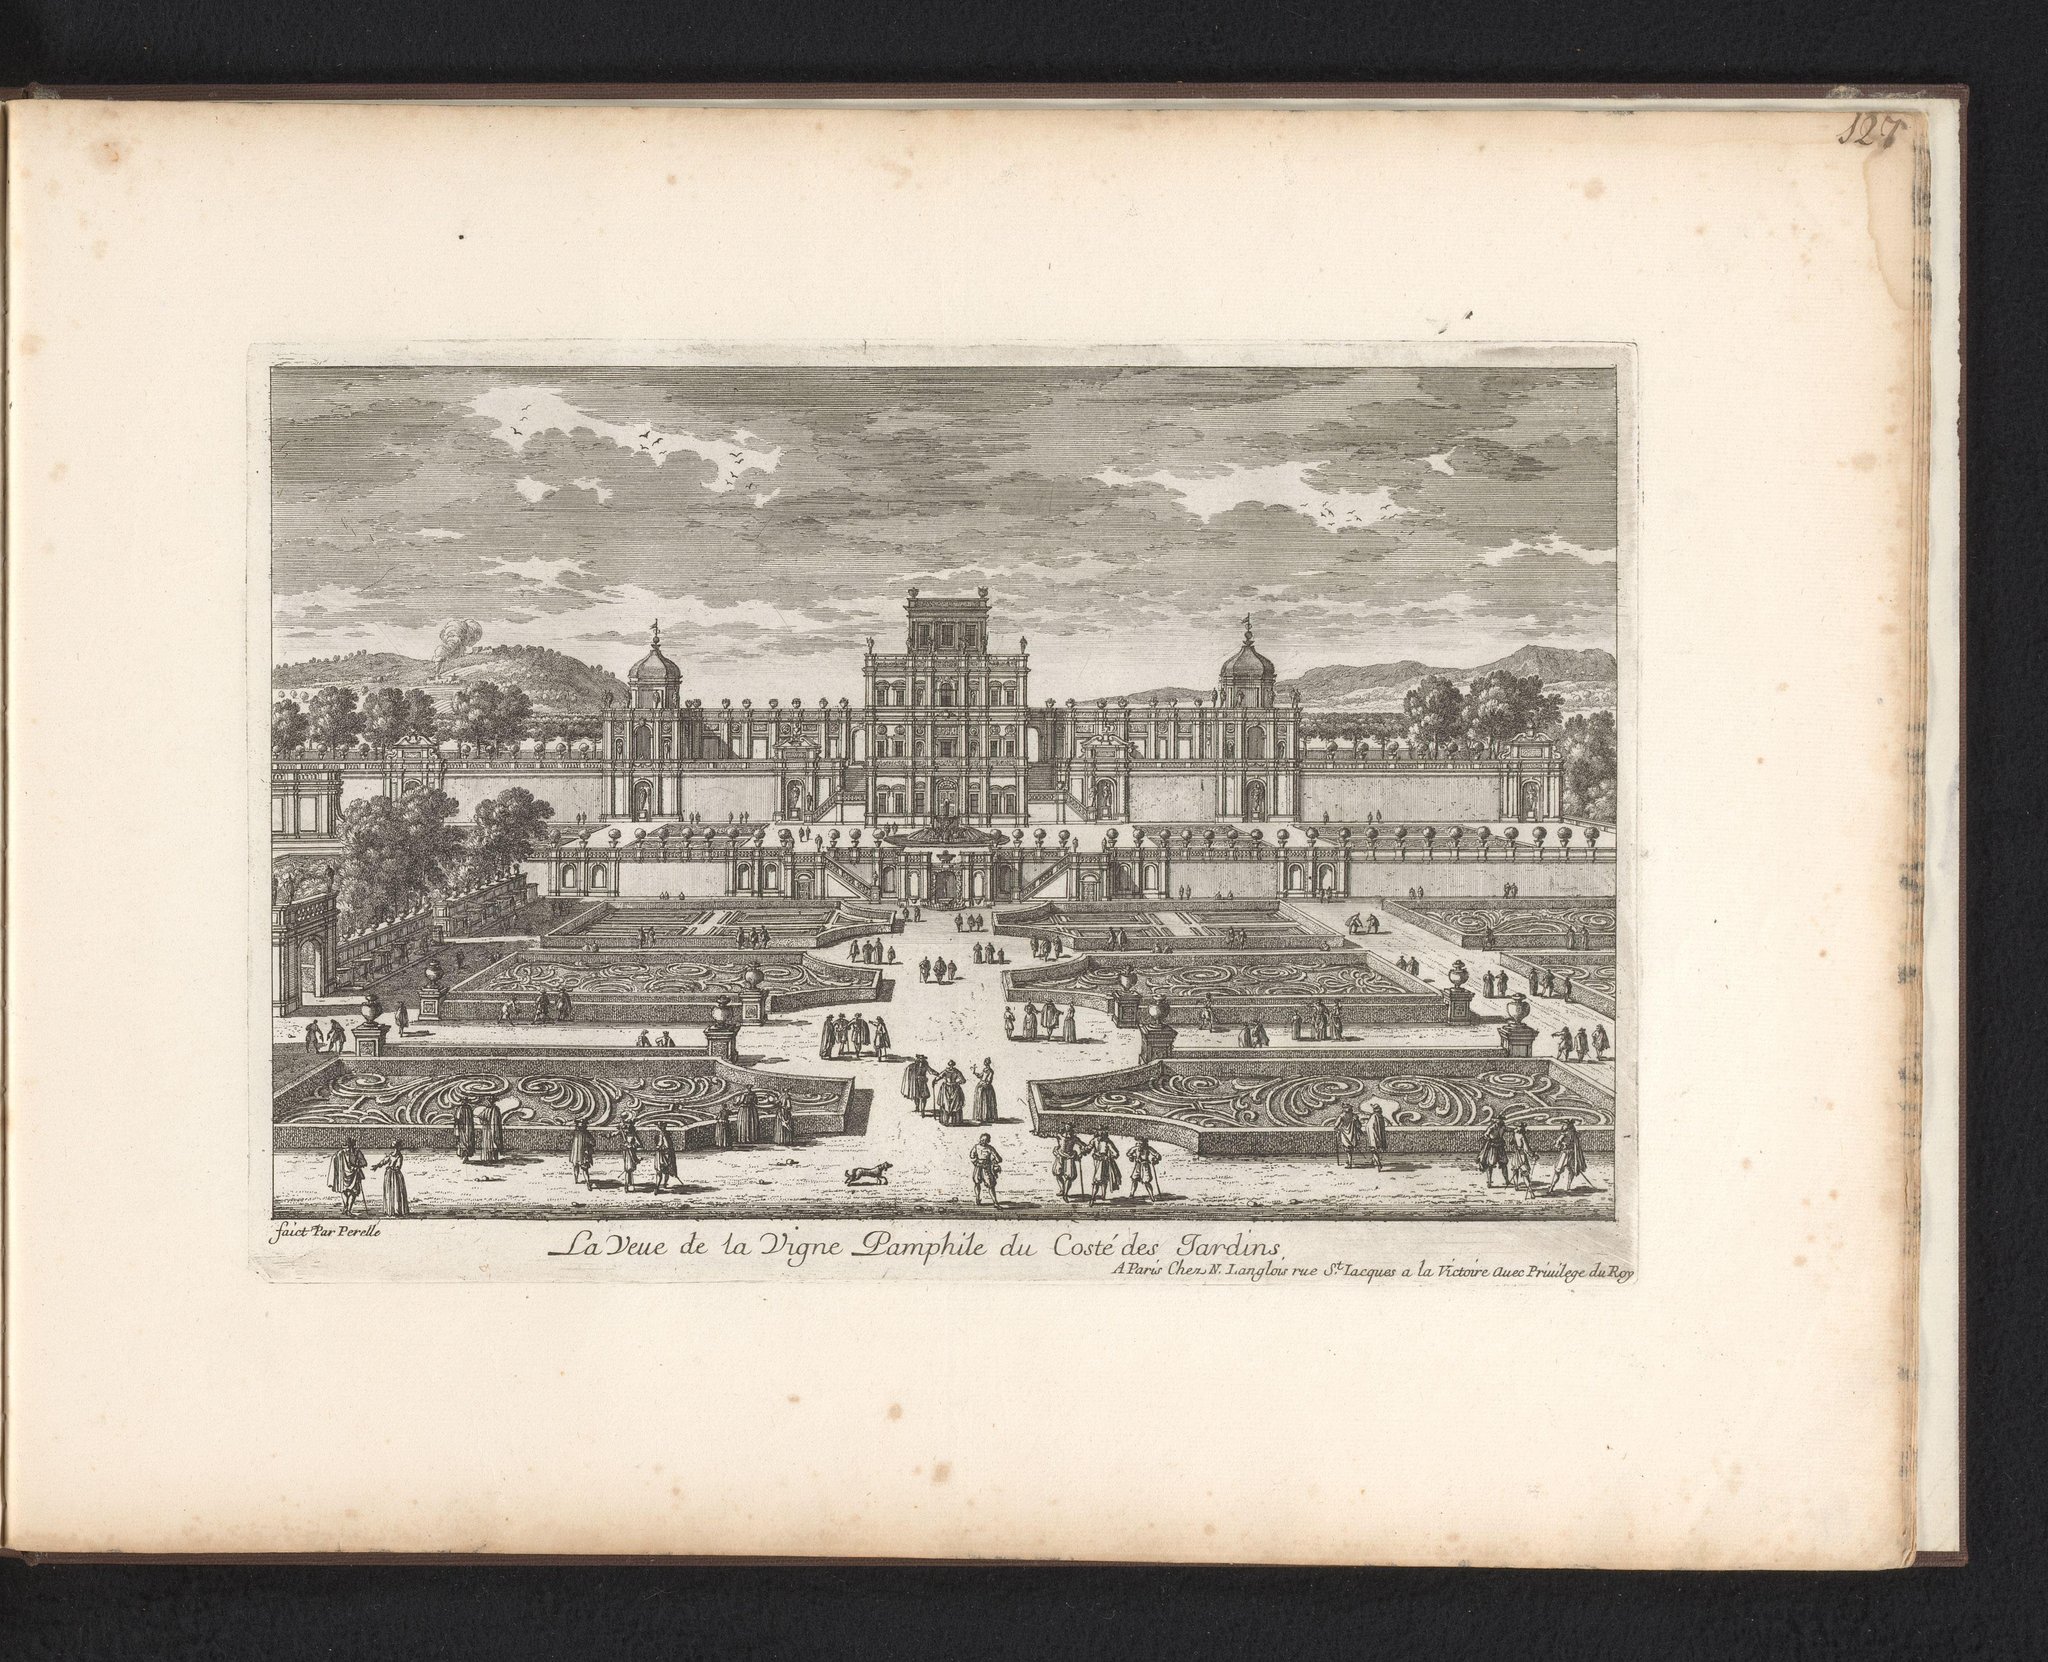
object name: album leaf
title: La Veue de la Vigne Pamphile du Costé des Jardins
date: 1650-1695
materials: paper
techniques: etching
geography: france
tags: french or architectonic garden; formal garden, villa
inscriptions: collector's mark: Lugt 2228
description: Prenten met het signatuur 'Perelle' kunnen zowel door vader Gabriel als door zonen Nicolas en Adam gemaakt zijn. De uitgevers vader en zoon Nicolas Langlois worden allebei vermeld als N. Langlois op hetzelfde adres.